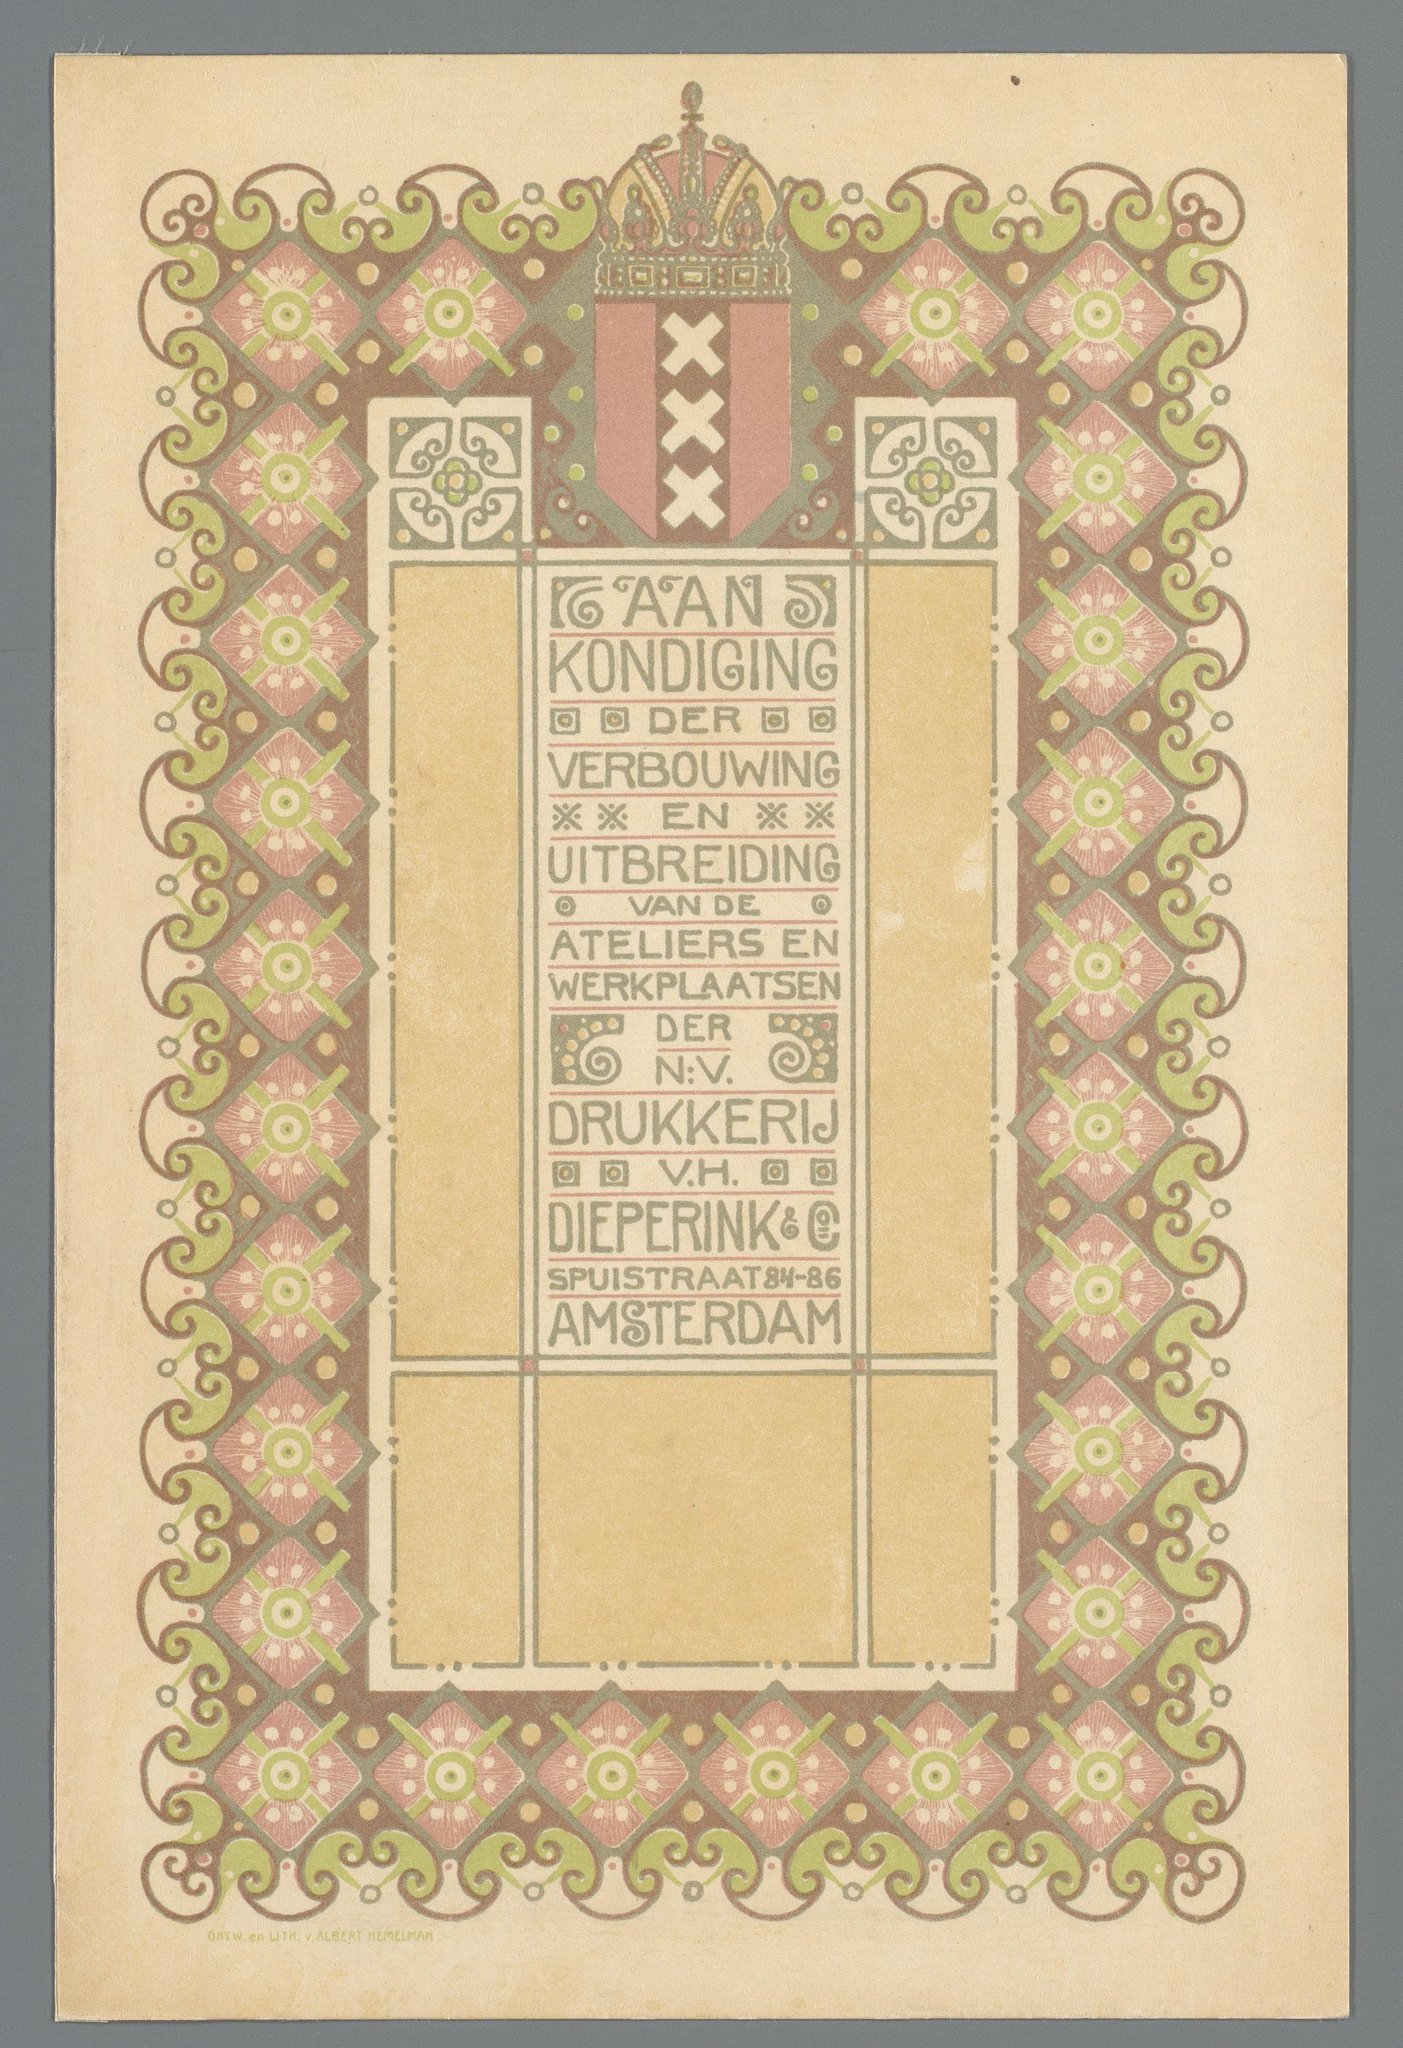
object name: moving announcement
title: Aankondiging van verbouwing en uitbreiding van N.V. Drukkerij v.h. Dieperink & Co.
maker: albert hemelman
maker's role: draughtsman, print maker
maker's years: 1883-1951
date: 1907-1912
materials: paper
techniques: lithograph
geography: amsterdam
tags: coat of arms (as symbol of the state, etc.), ornaments ~ art, amsterdam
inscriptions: collector's mark: Lugt 2228, collector's mark: Lugt 2760, annotation: ‘Albert Hemelman. Hooimaand 1912.’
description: Een decoratief kader met in het midden de tekst van de aankondiging, onder het stadswapen van Amsterdam.